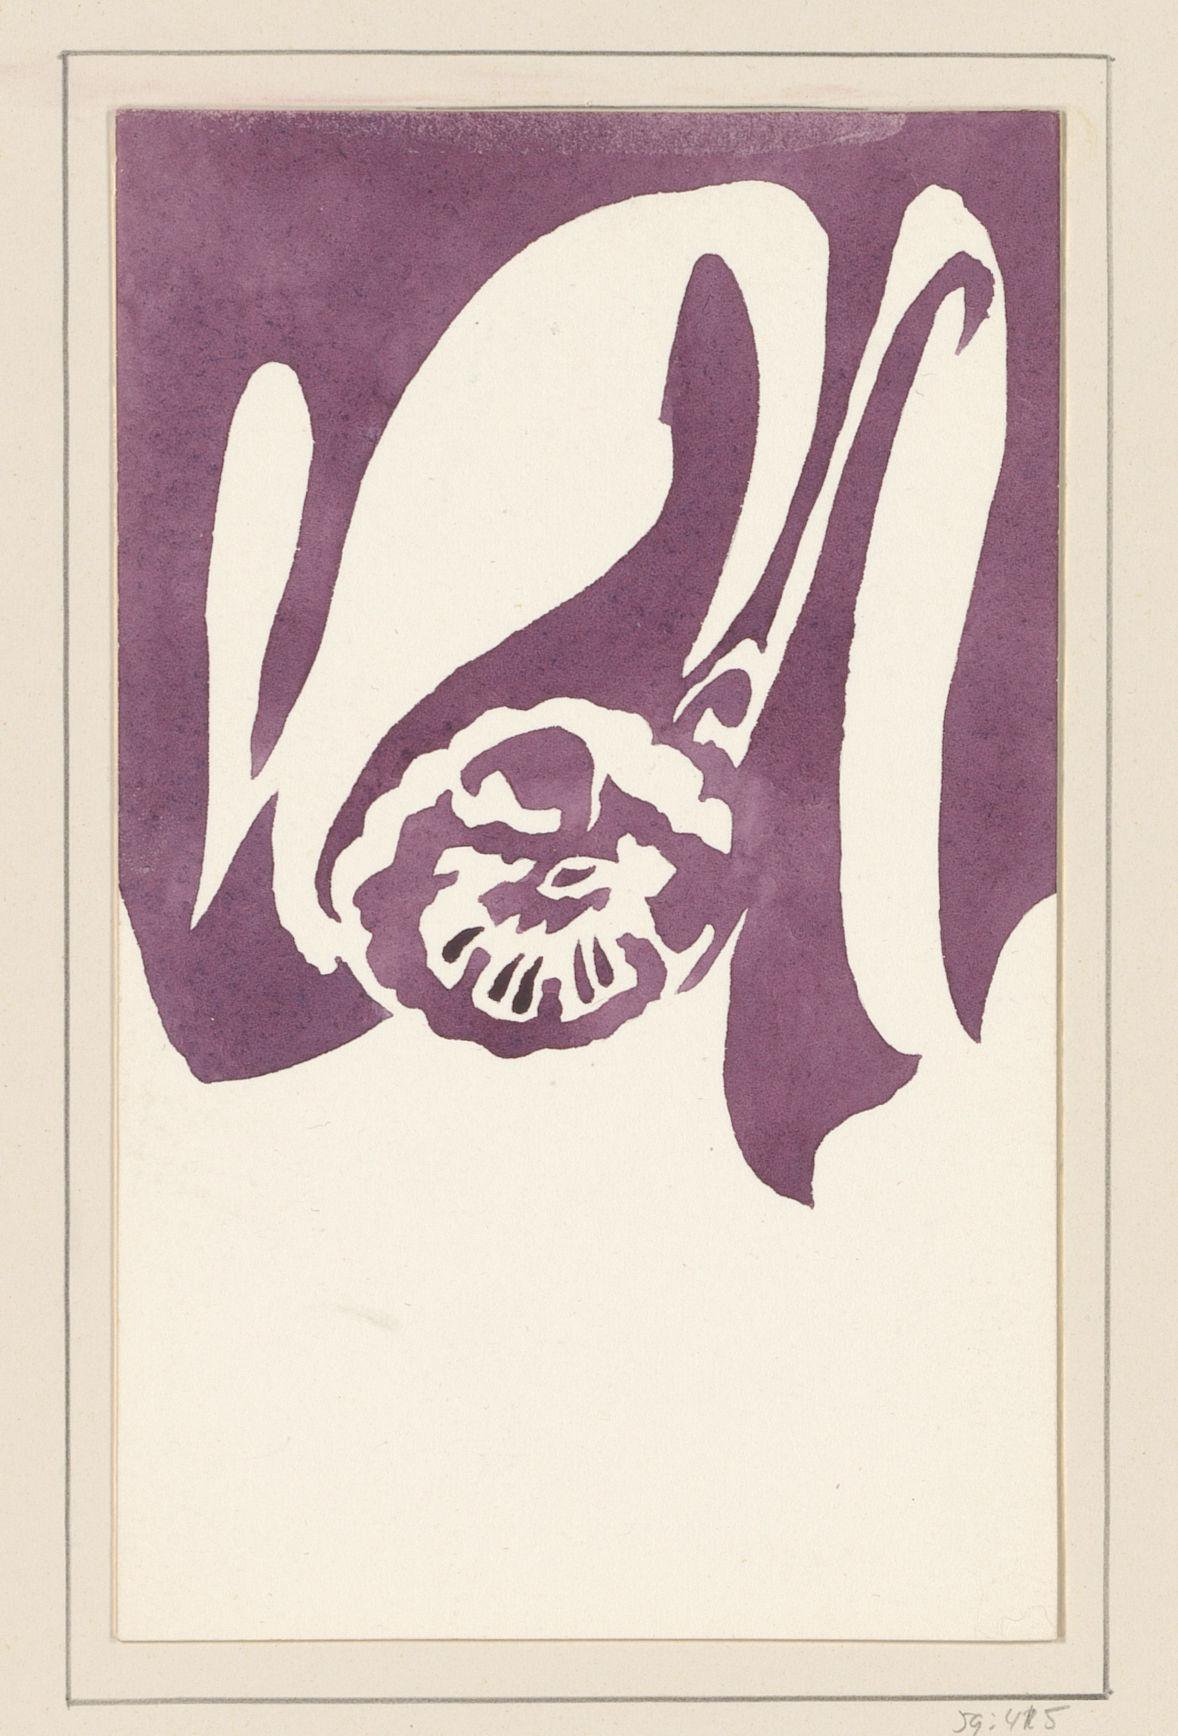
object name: drawing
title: Ontwerp voor een menukaart met bloemmotief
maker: theo colenbrander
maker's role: draughtsman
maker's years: 1841-1930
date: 1851-1930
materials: paper, pencil, watercolor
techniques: brush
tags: ornament derived from plant forms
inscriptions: number: ‘1.’